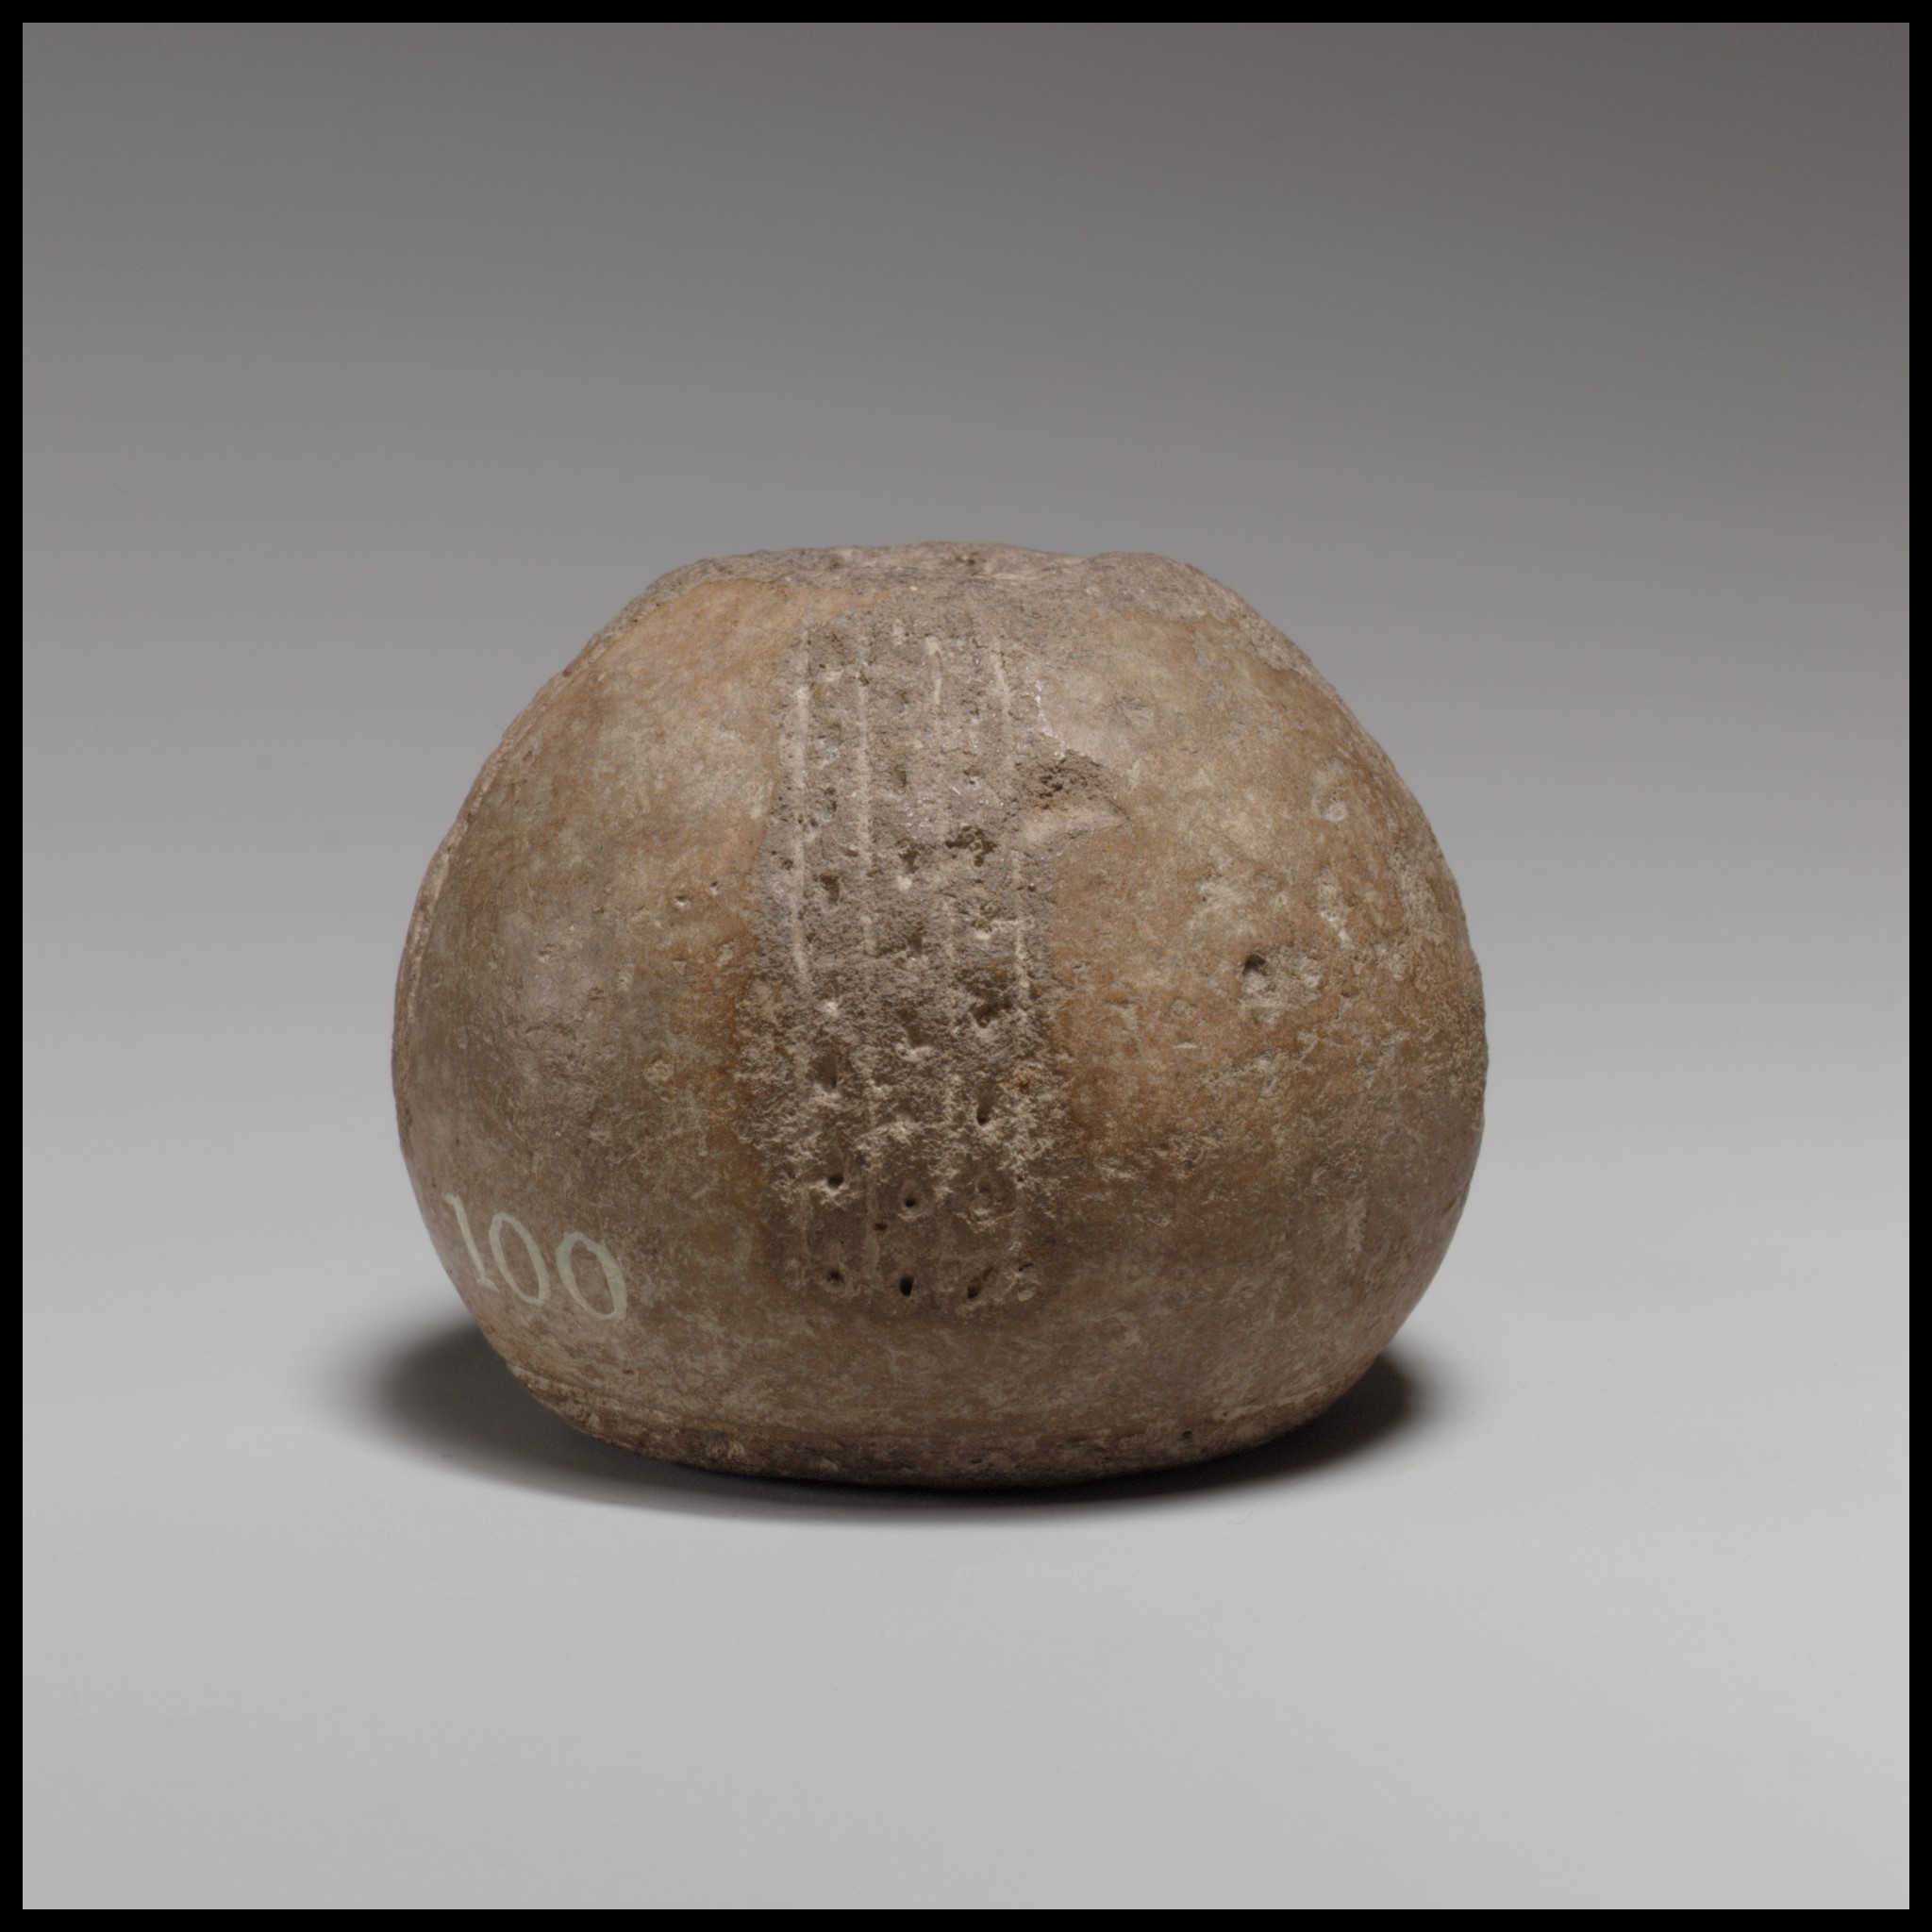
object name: spindle whorl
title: Terracotta conical-hemispherical spindle-whorl with flat base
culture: cypriot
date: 2000-1725 BCE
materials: terracotta